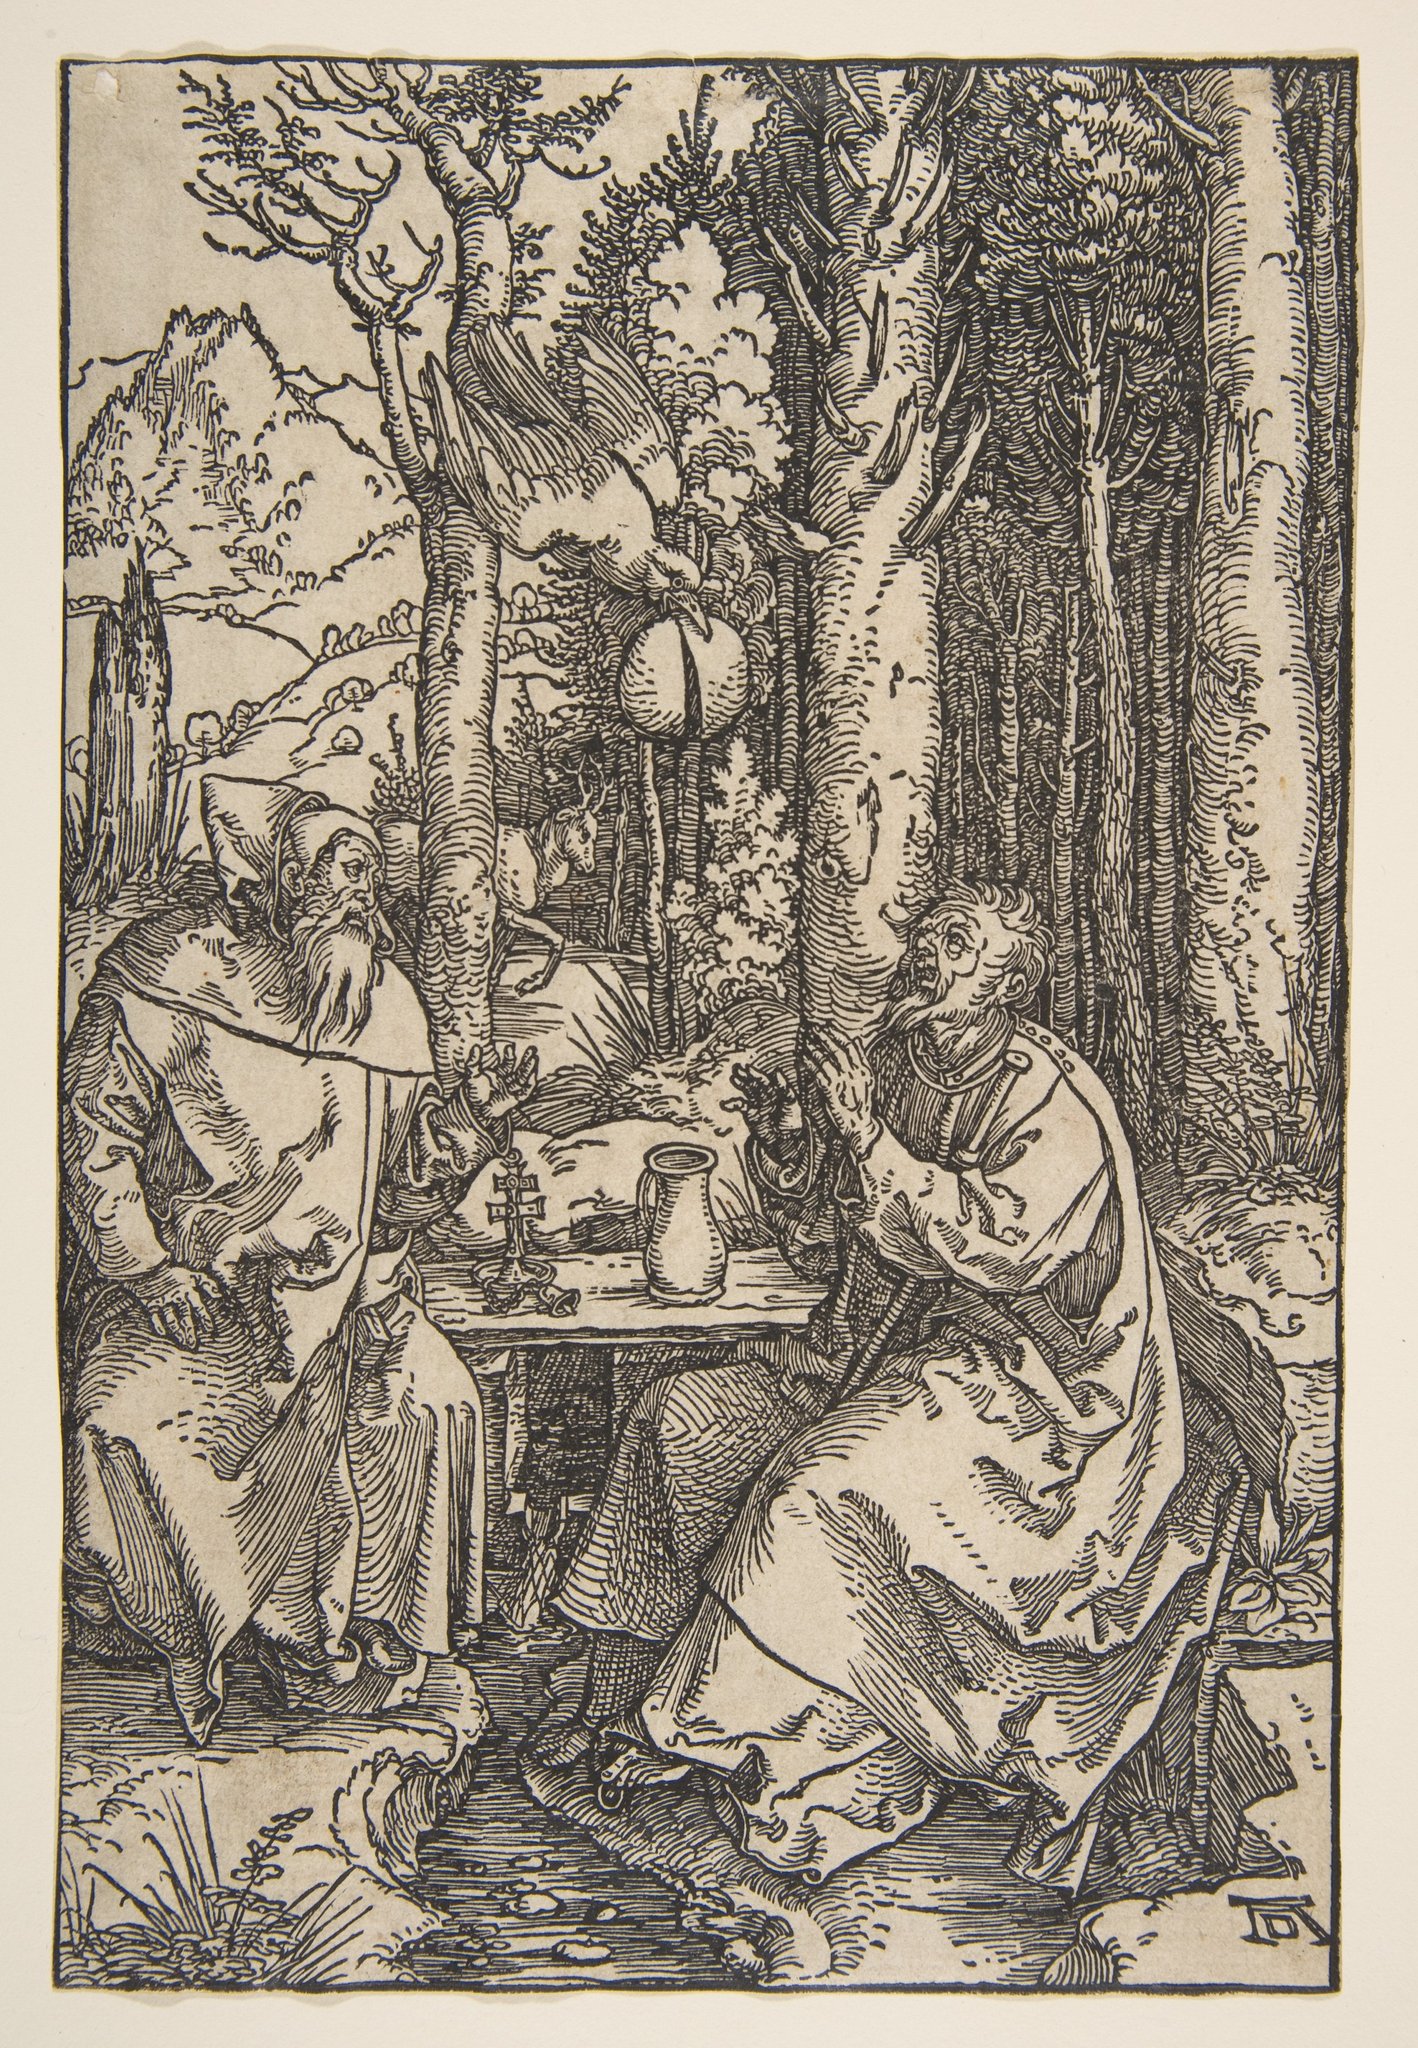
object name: print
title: Saint Anthony and Saint Paul in the Desert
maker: albrecht dürer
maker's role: artist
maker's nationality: german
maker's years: 1471-1528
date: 1503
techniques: woodcut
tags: birds,trees,saint paul